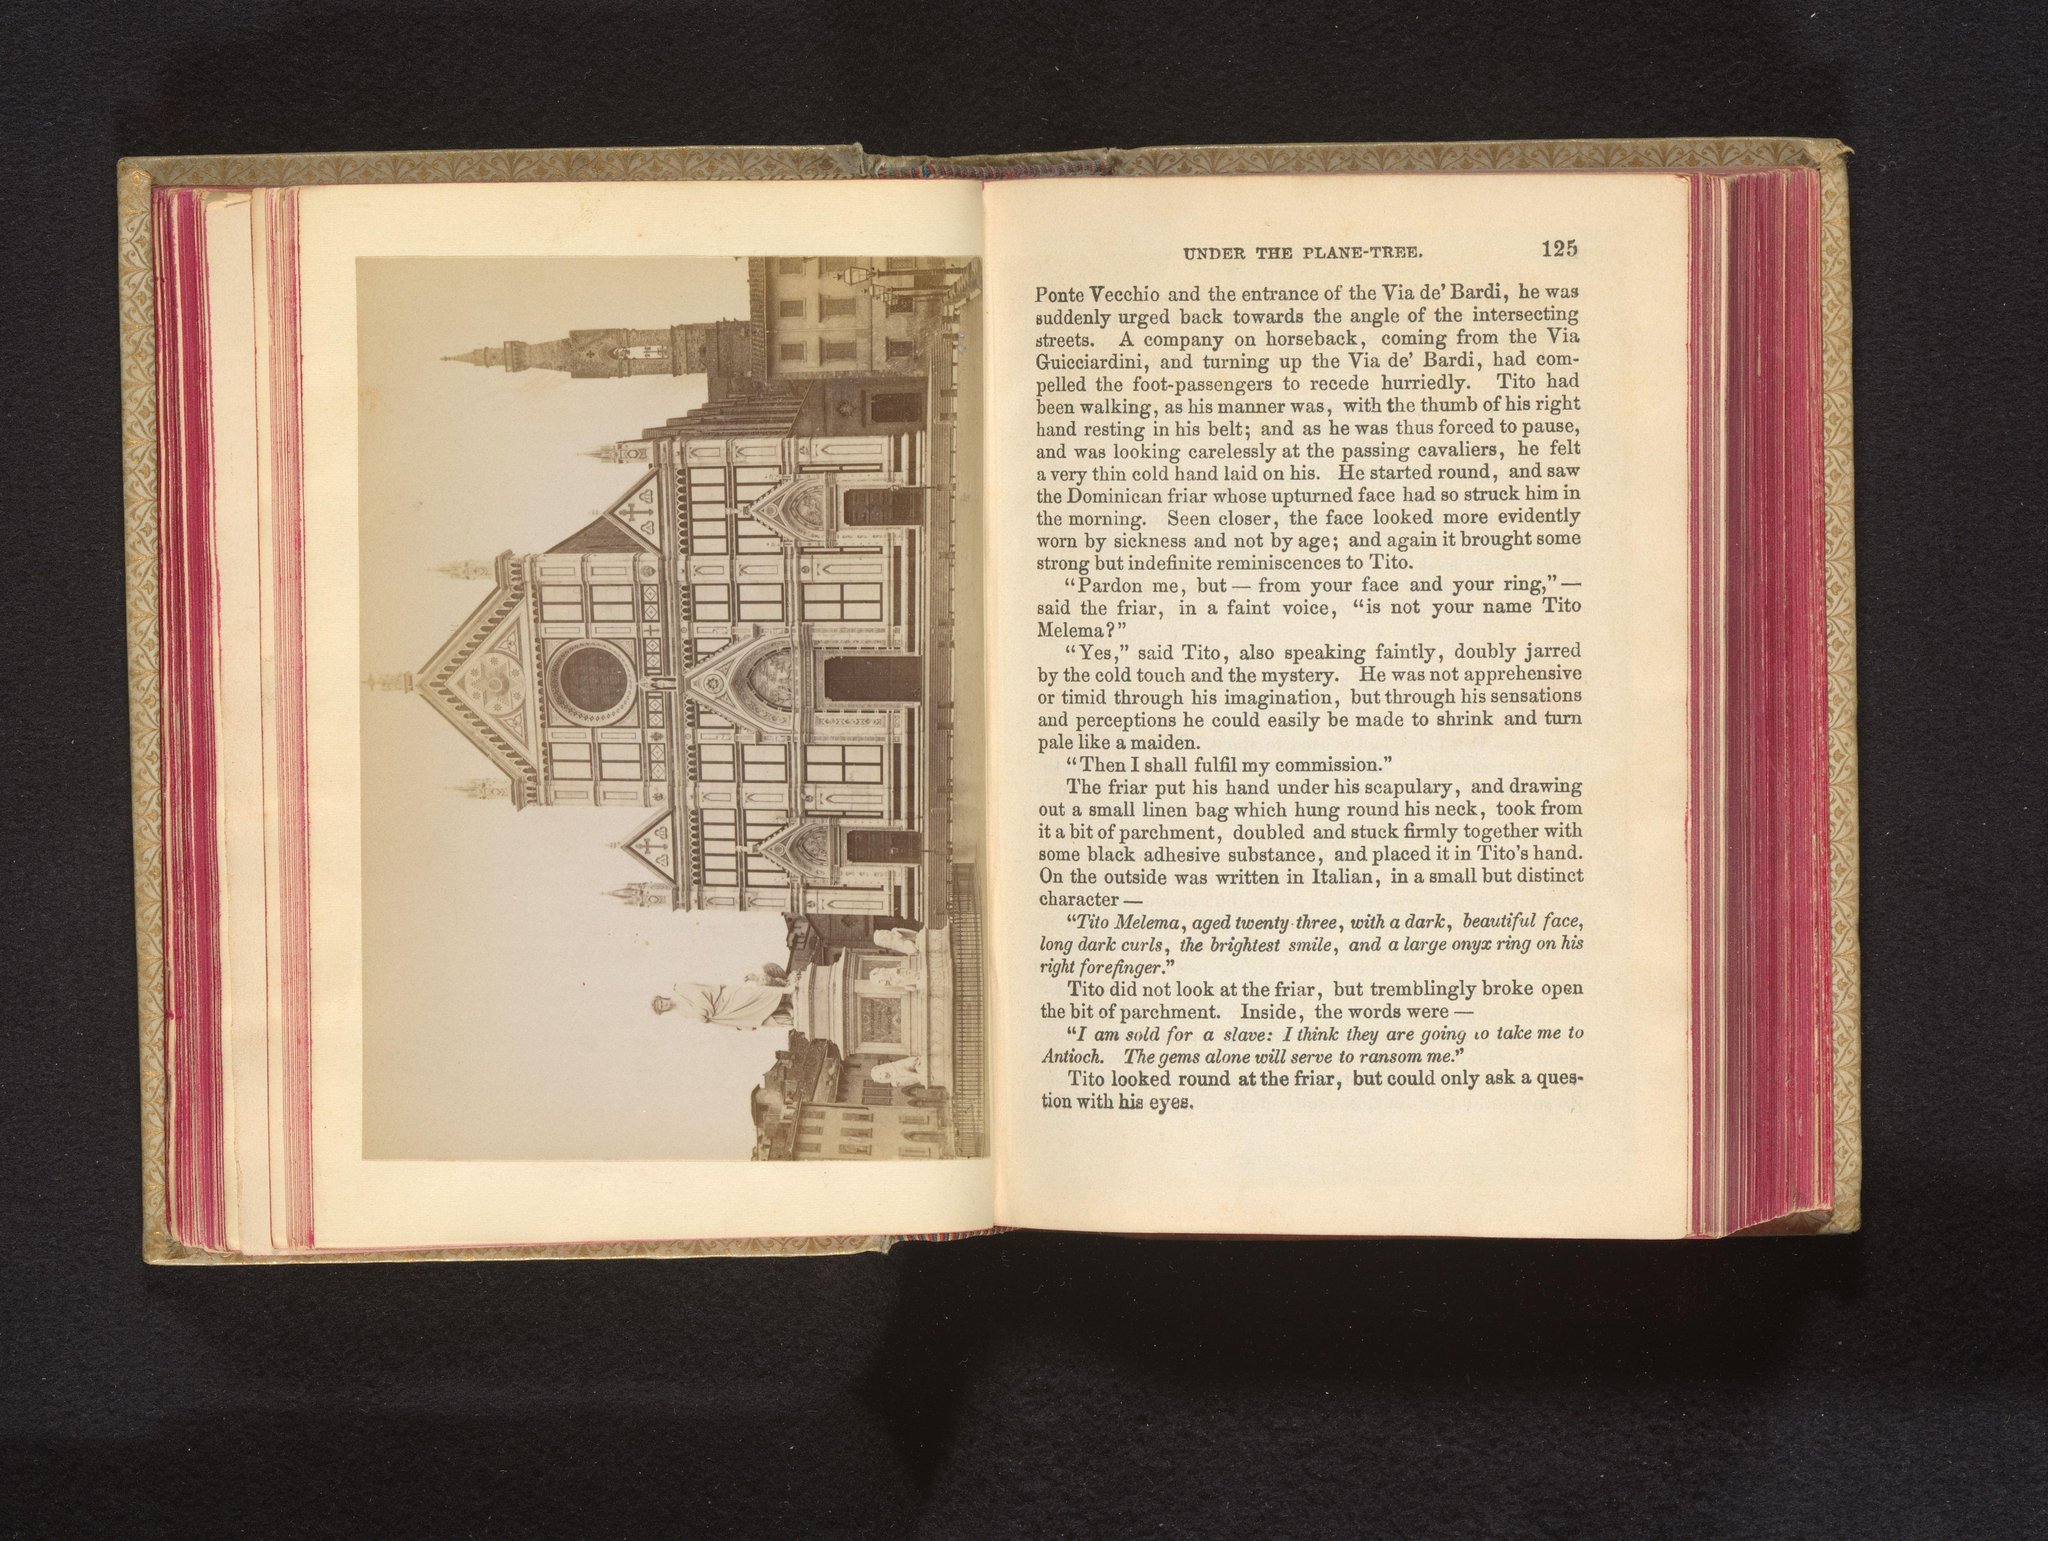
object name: photograph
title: Exterieur van de Santa Croce te Florence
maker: Anonymous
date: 1858-1863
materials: photographic support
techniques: albumen print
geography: florence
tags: church (exterior), façade (of house or building)